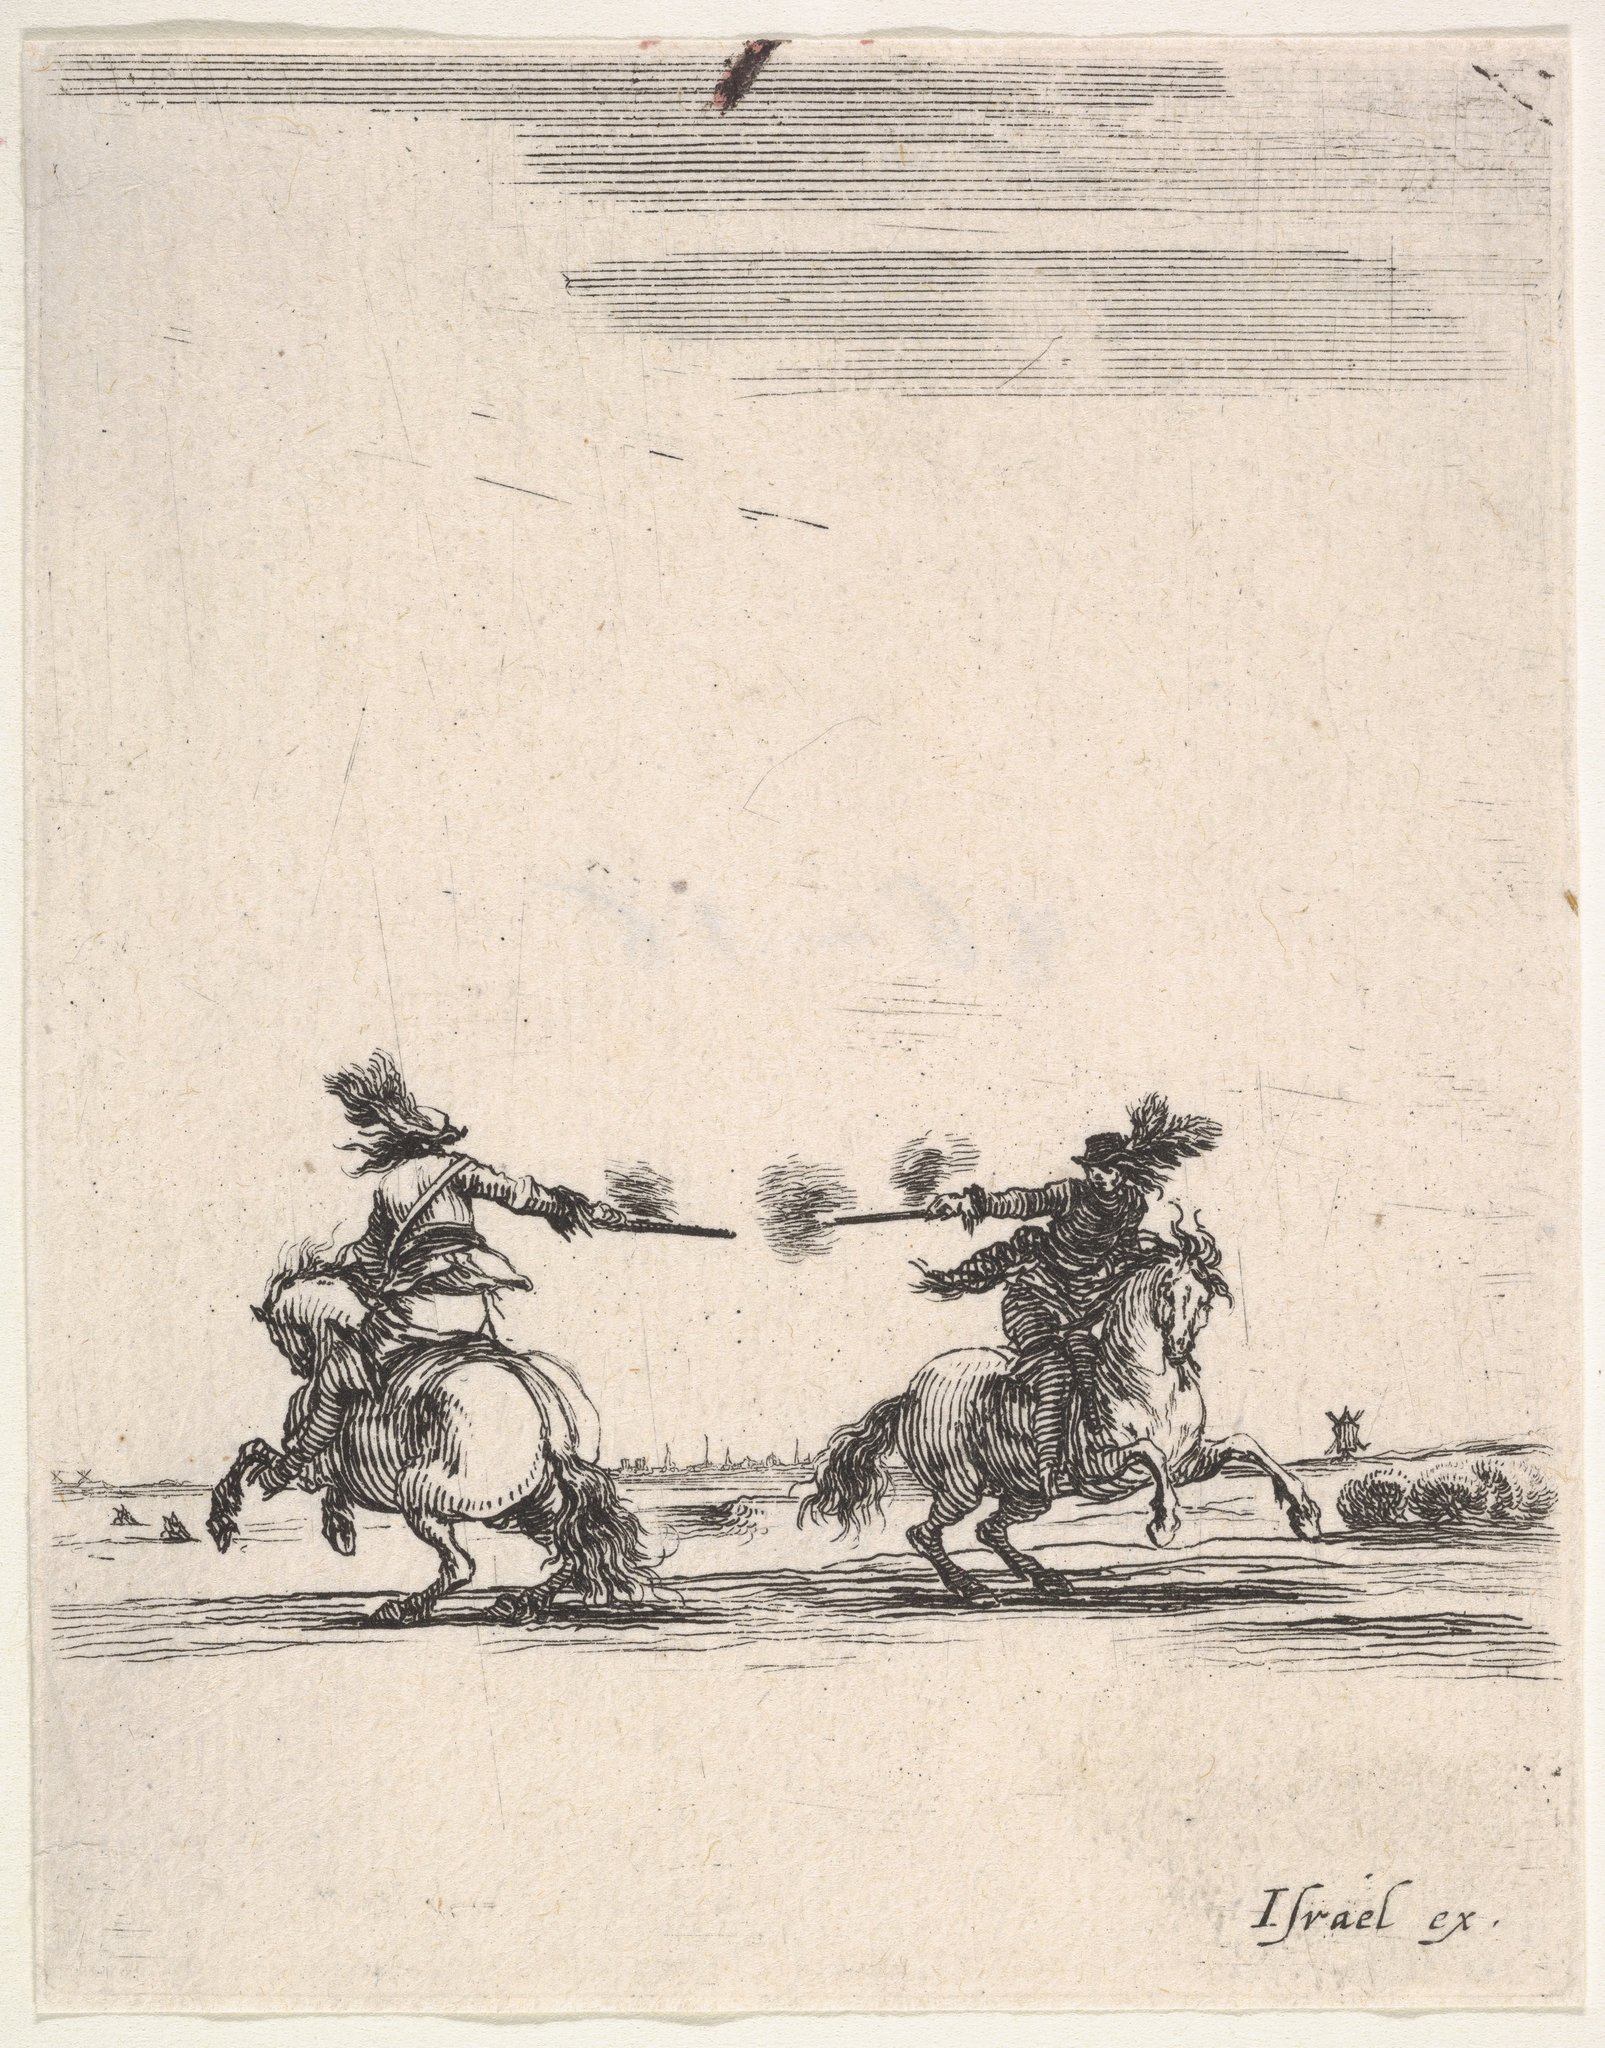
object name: print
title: Two horsemen dueling with pistols, one seen from behind riding towards the left, one riding towards right, from "Various cavalry exercises" (Diverses exercices de cavalerie)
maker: stefano della bella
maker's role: artist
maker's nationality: italian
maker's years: 1610-1664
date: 1642-1645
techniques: etching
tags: firearms,men,horses